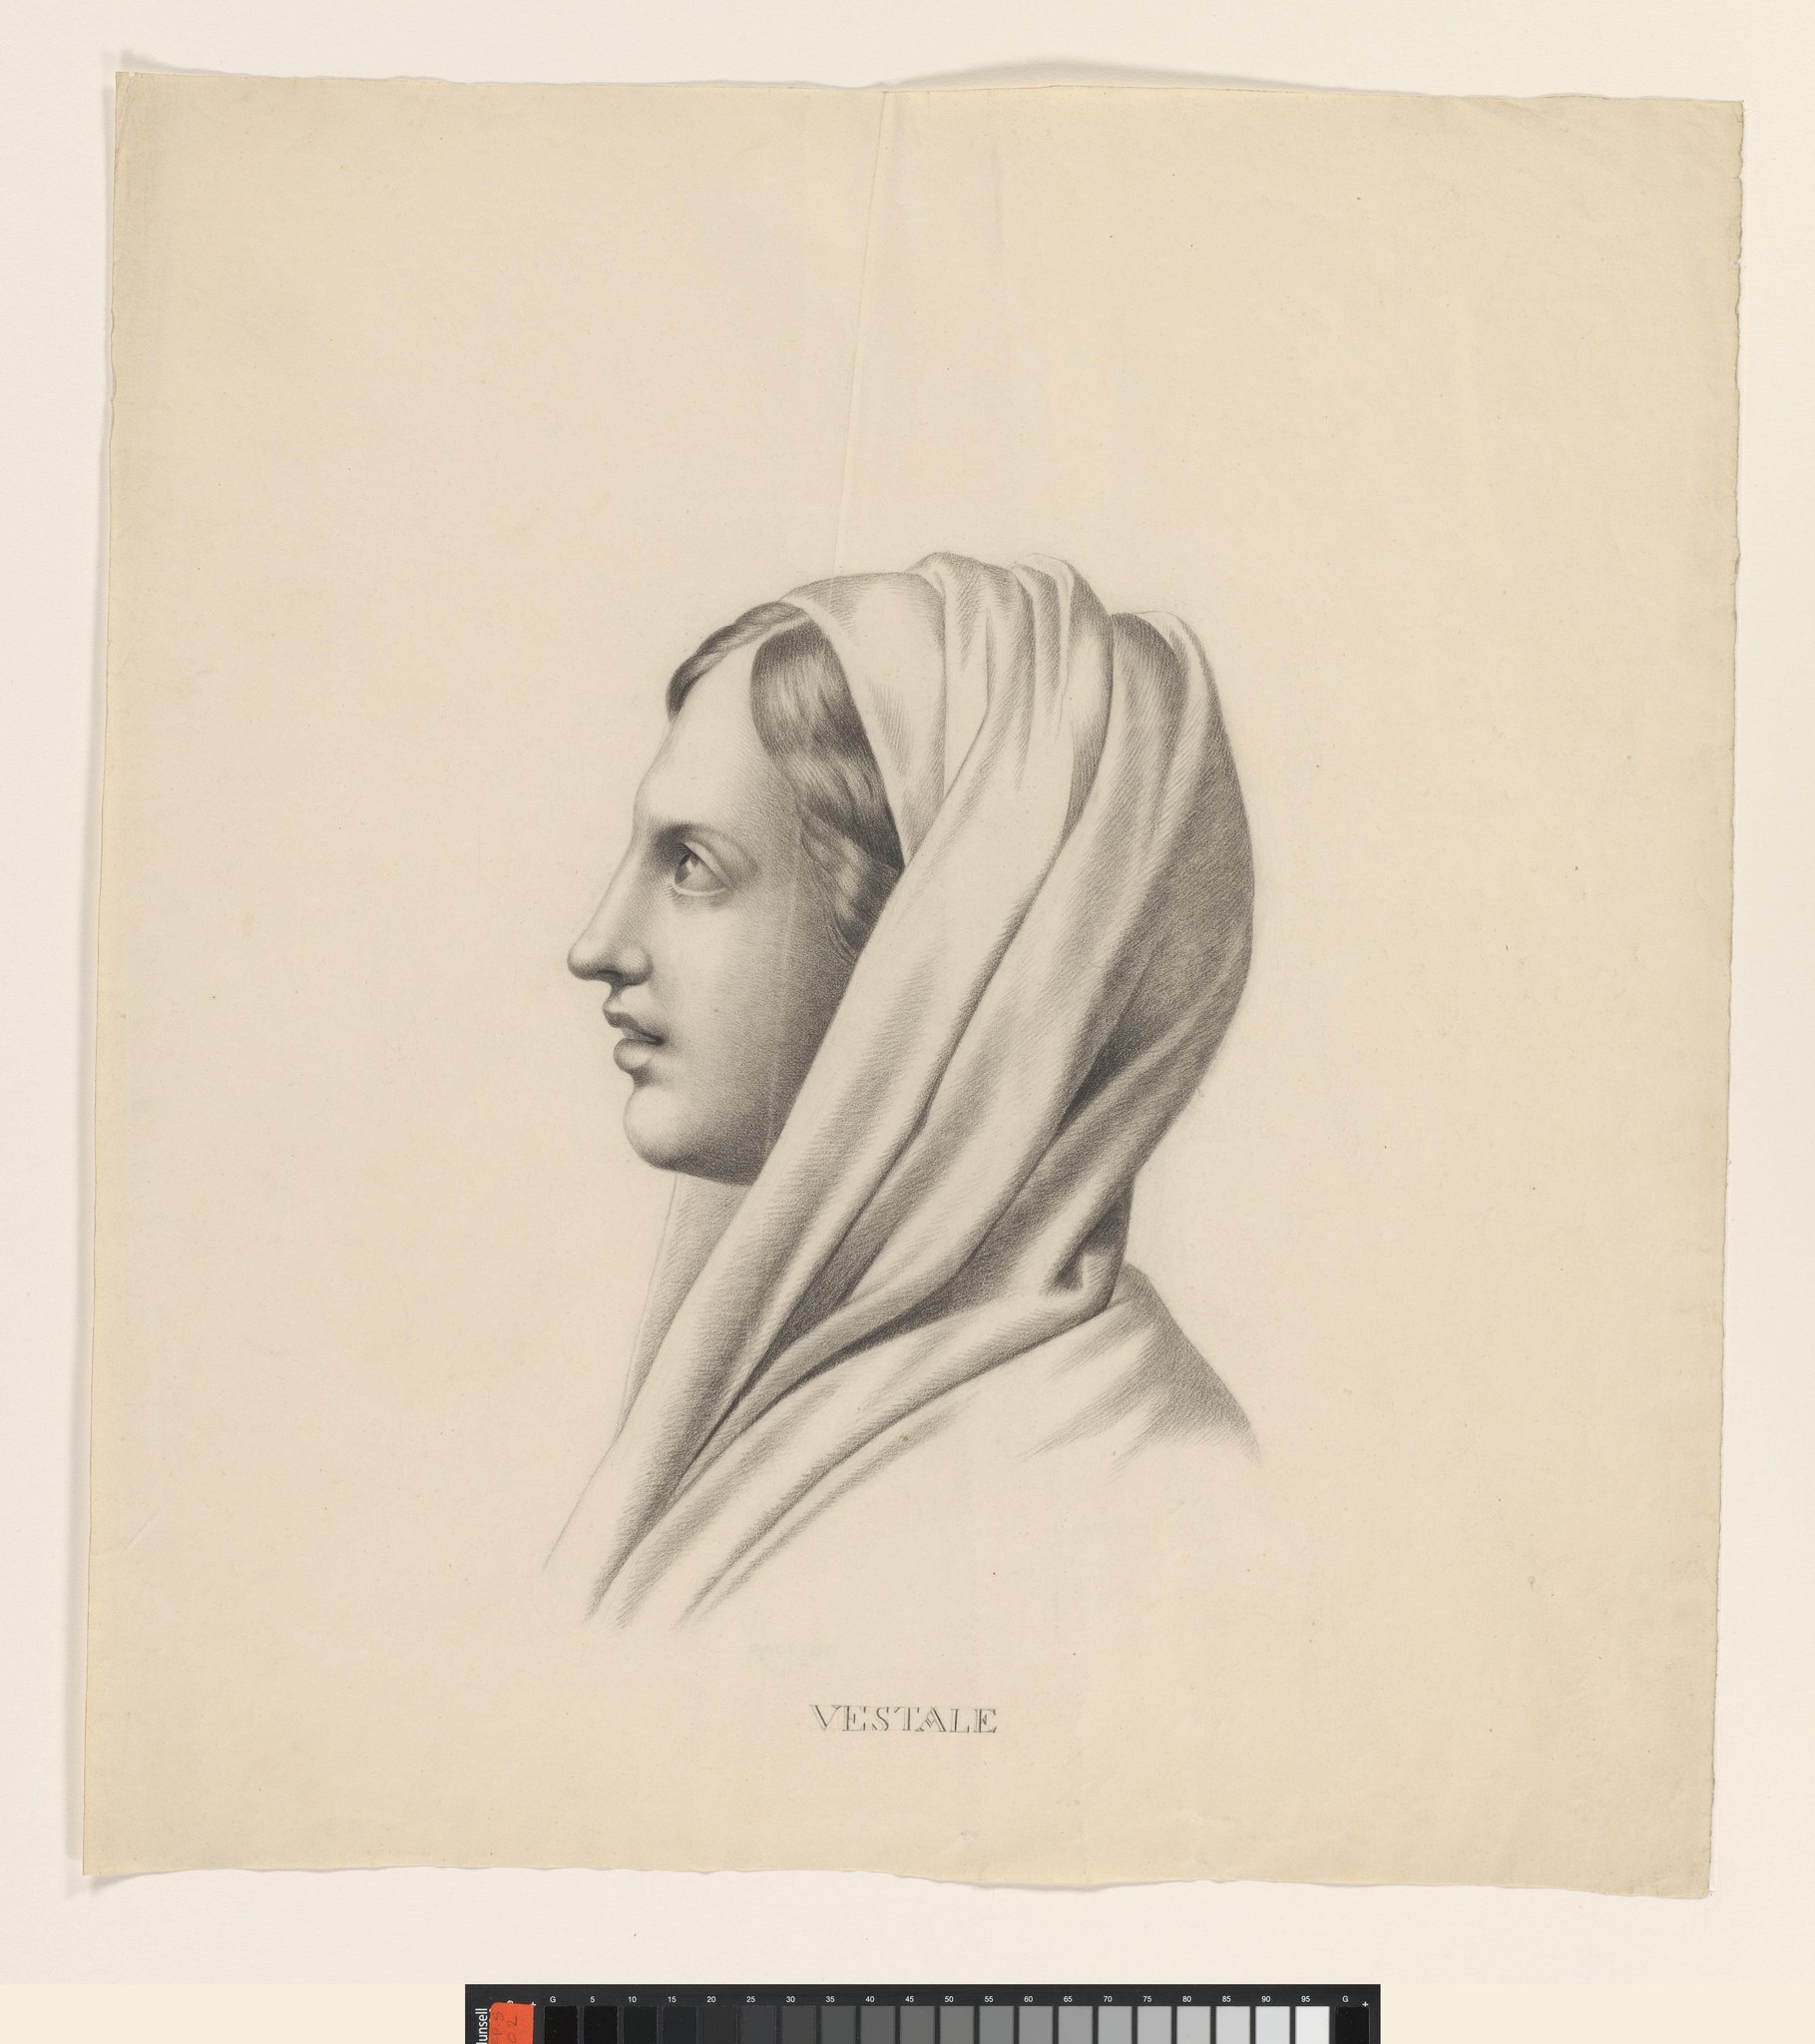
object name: drawing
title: Vestale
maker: Anonymous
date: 1800-1900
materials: chalk, paper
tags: vestal virgin(s)